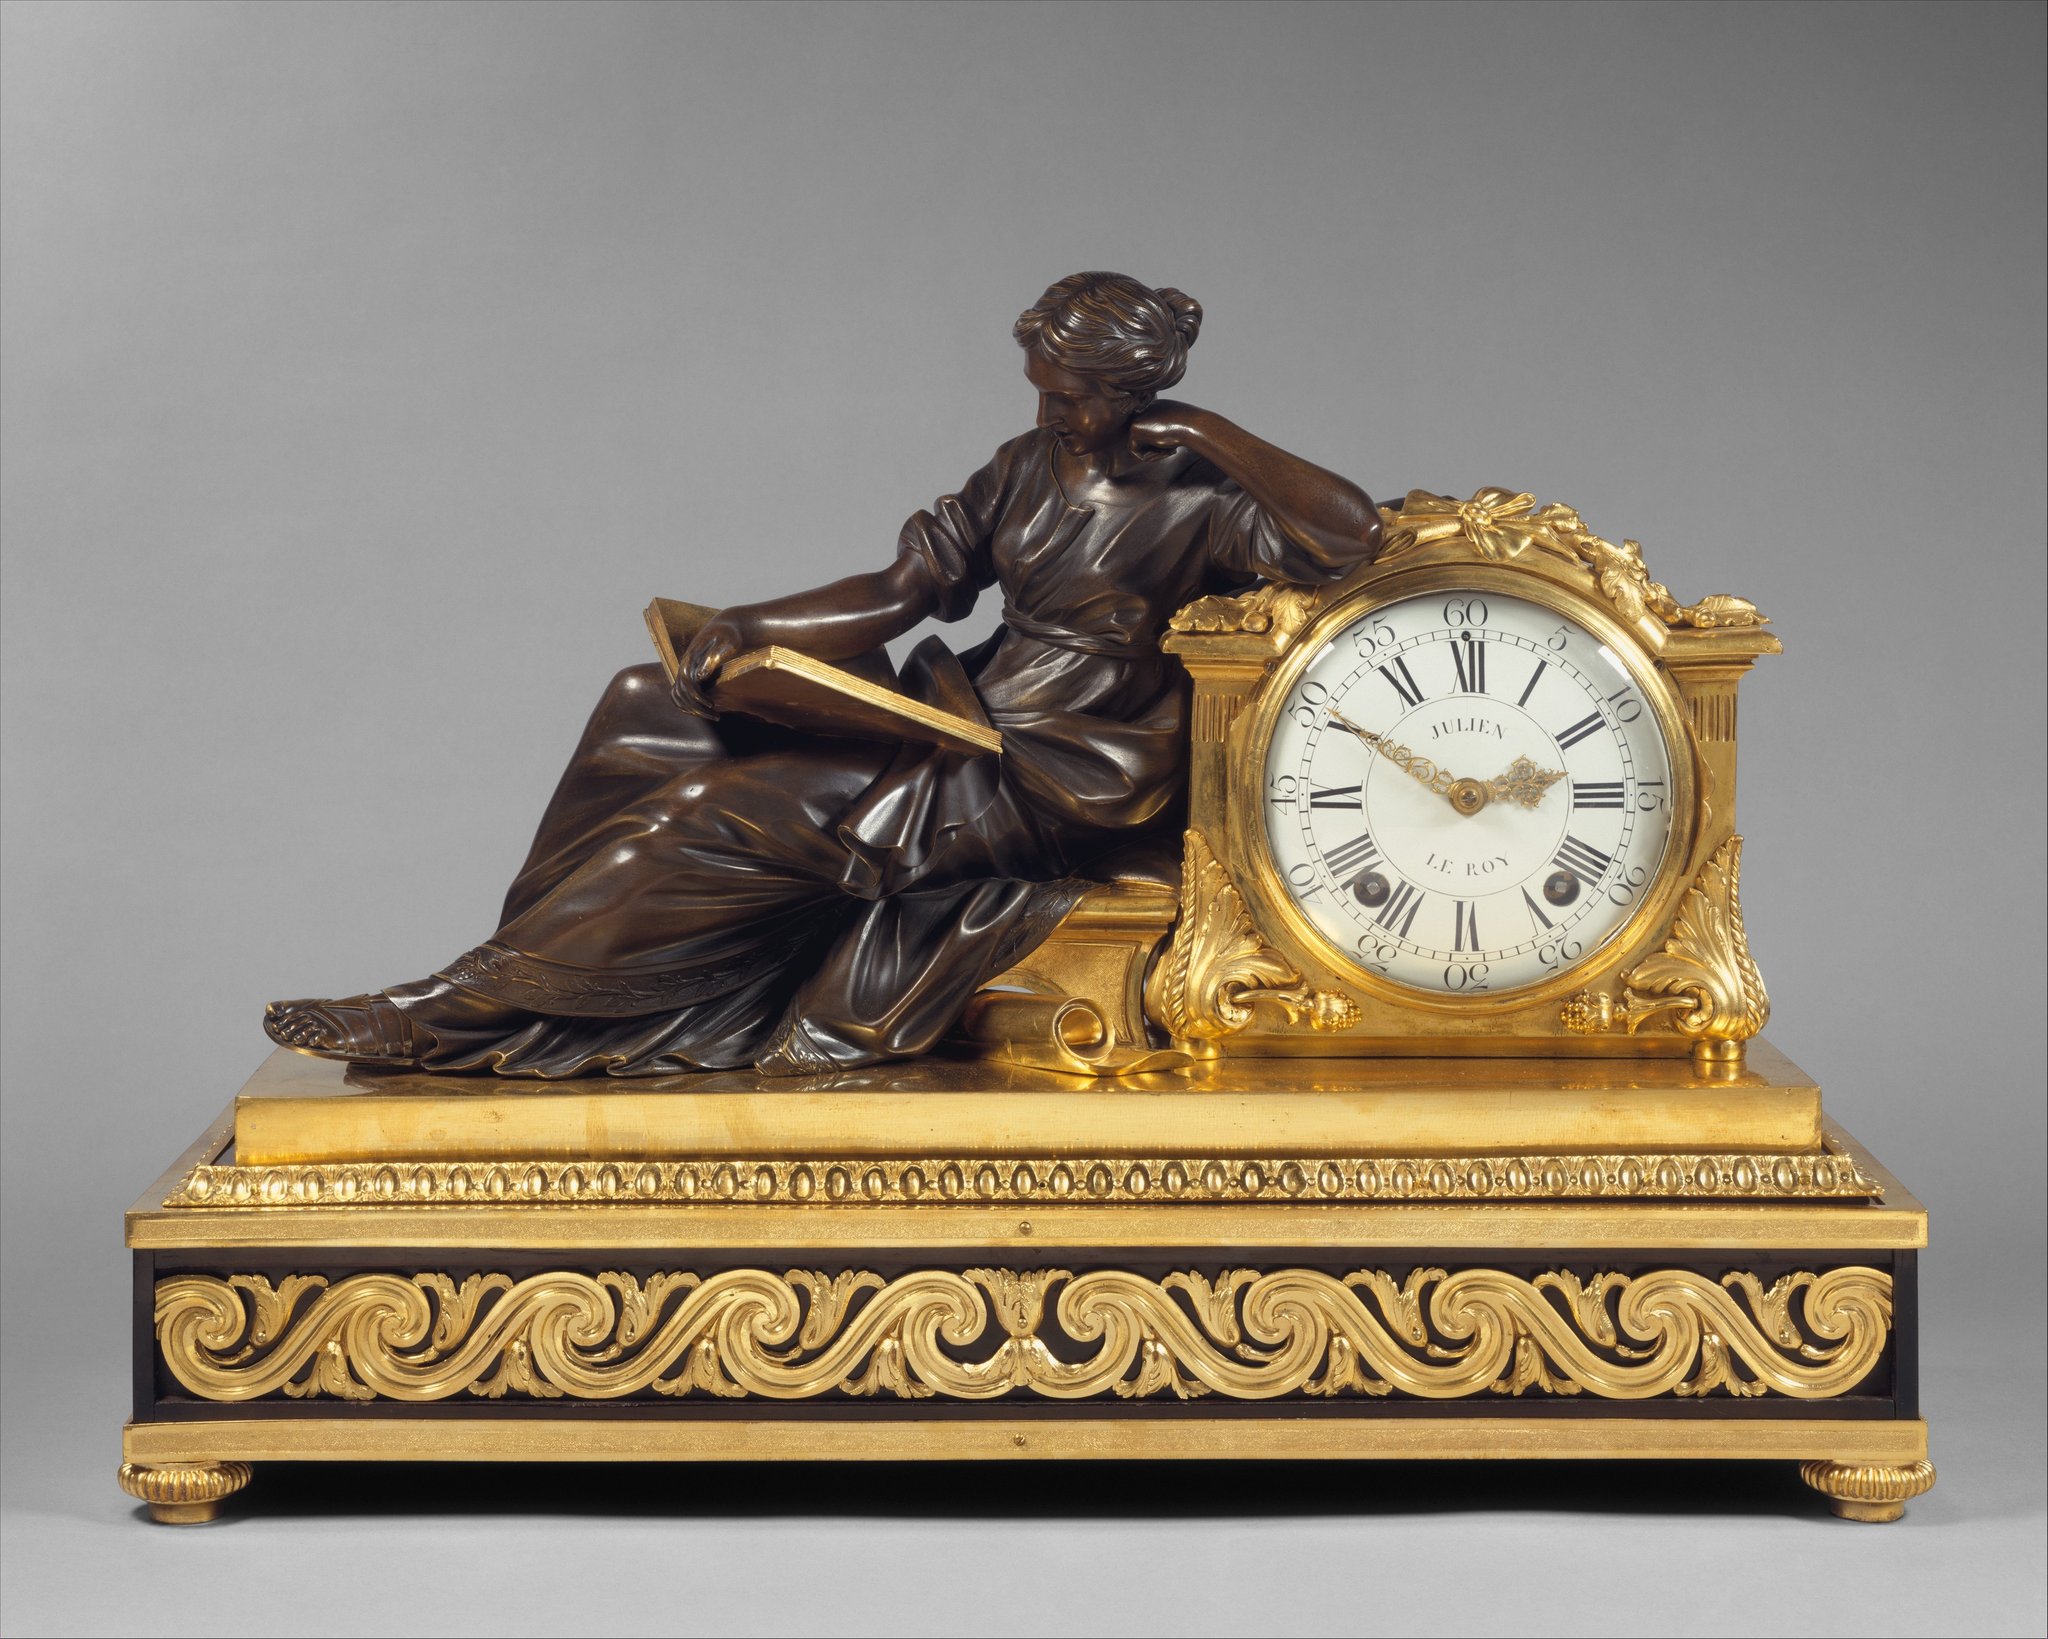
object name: mantel clock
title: Mantel clock (pendule de cheminée)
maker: julien le roy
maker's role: maker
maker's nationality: french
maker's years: 1686-1759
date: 1757-1760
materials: brass, bronze, wood, enamel, steel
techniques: gilding, veneering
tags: books,women,reading